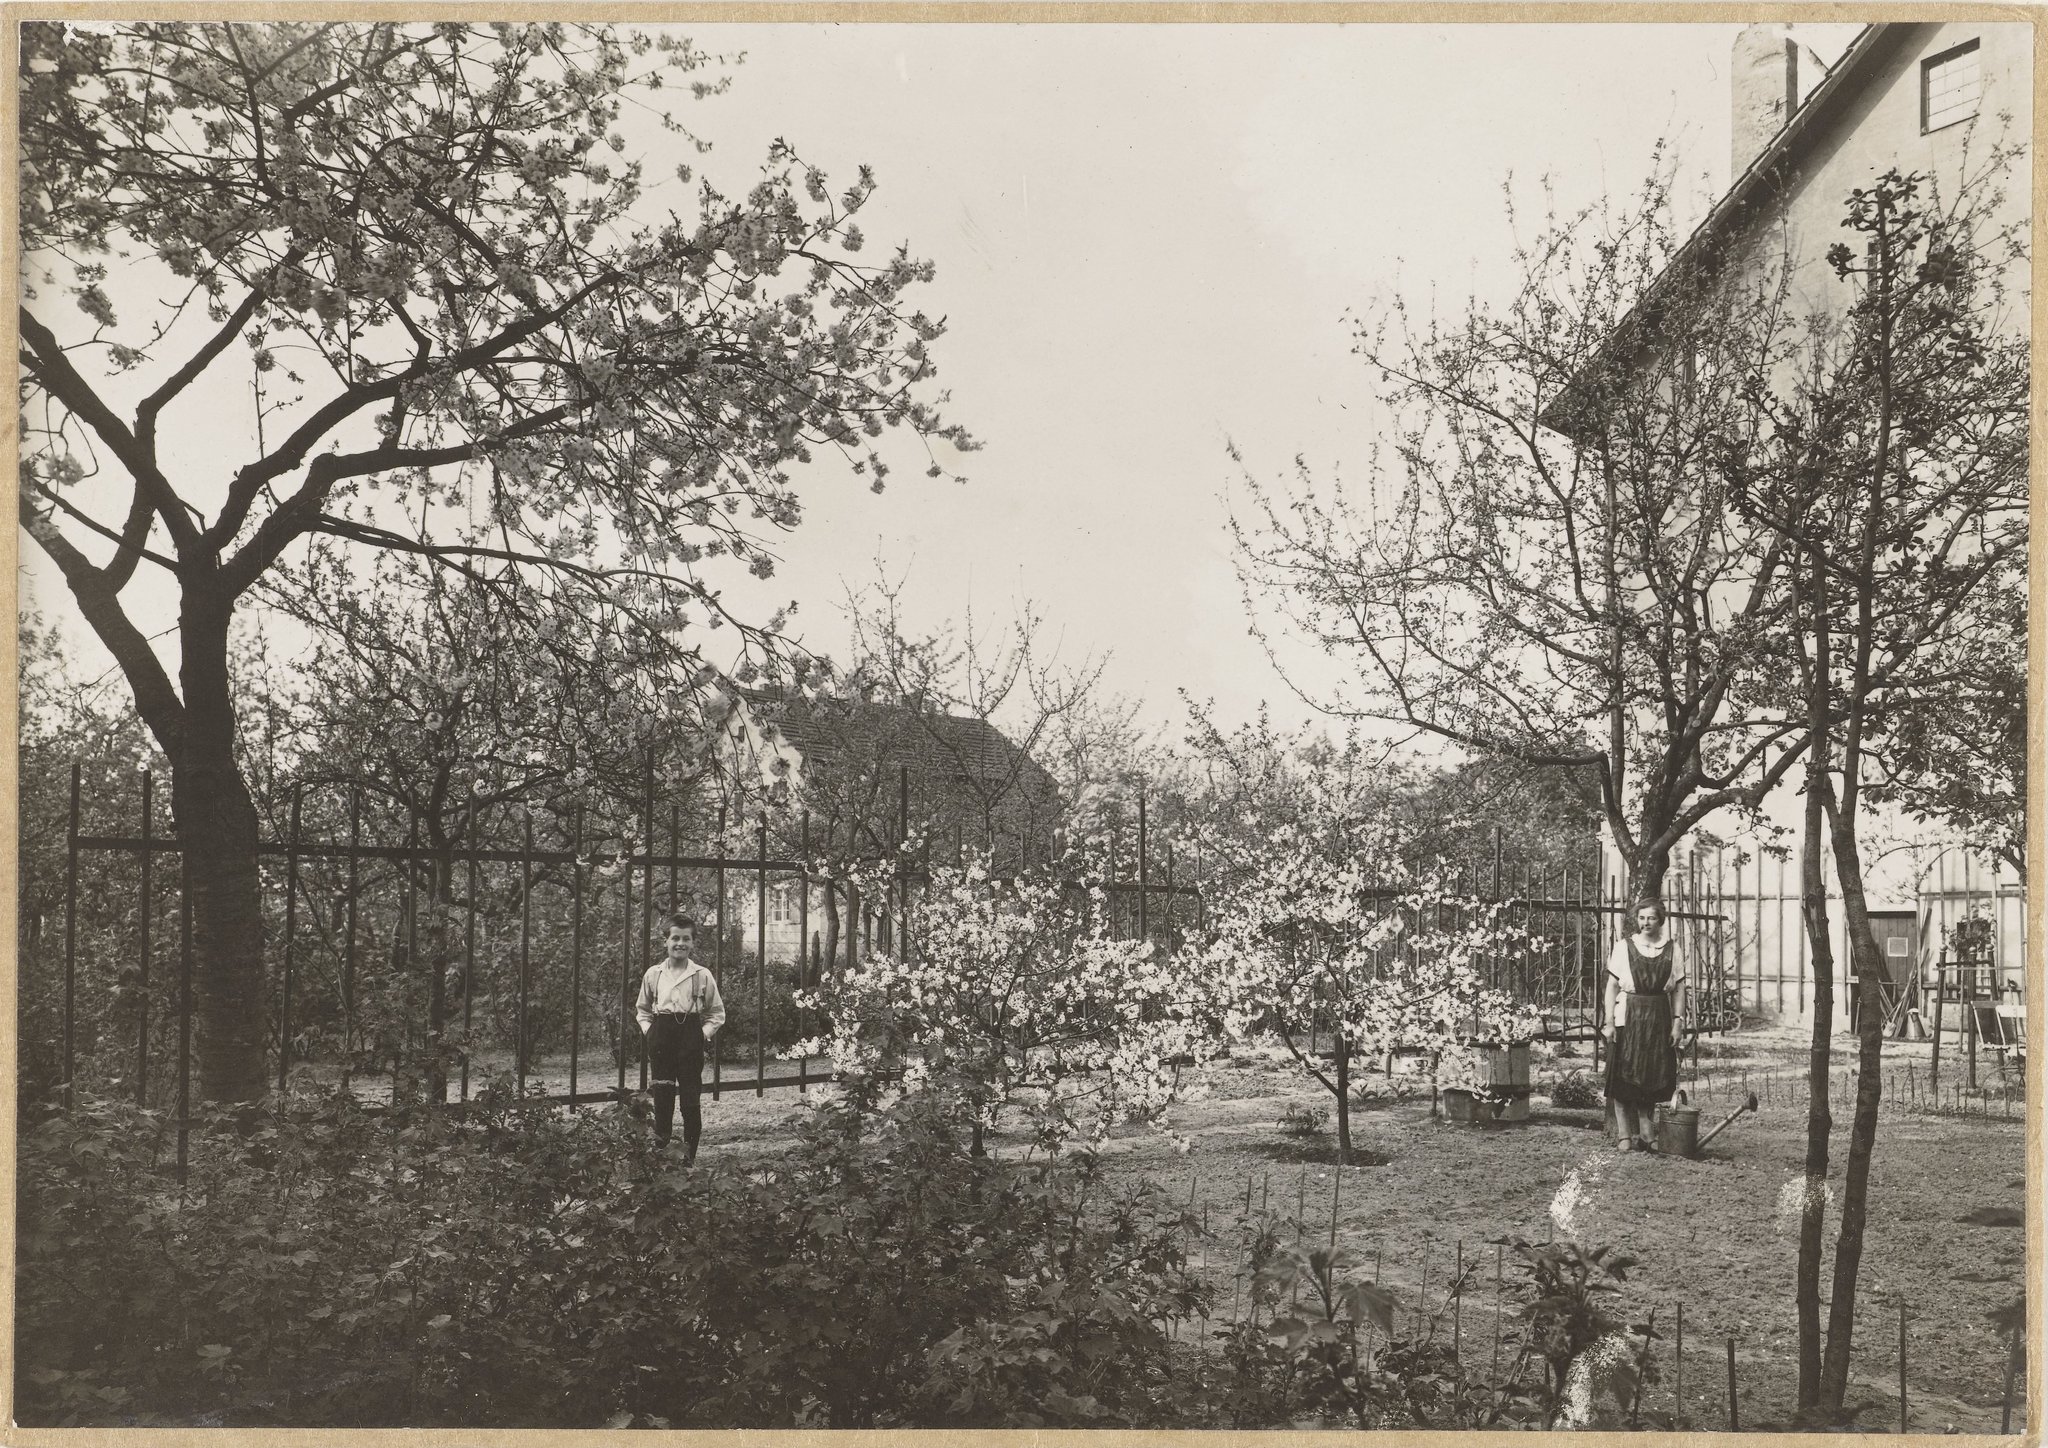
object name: photograph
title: Eckart en Marba Titzenthaler, kinderen van de fotograaf, in een tuin in Lichterfelde, Berlijn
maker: waldemar titzenthaler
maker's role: fotograaf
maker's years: 1869-1937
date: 1925-1930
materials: paper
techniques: gelatin silver print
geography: lichterfelde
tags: garden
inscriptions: inscription: ‘Lichterfelde’